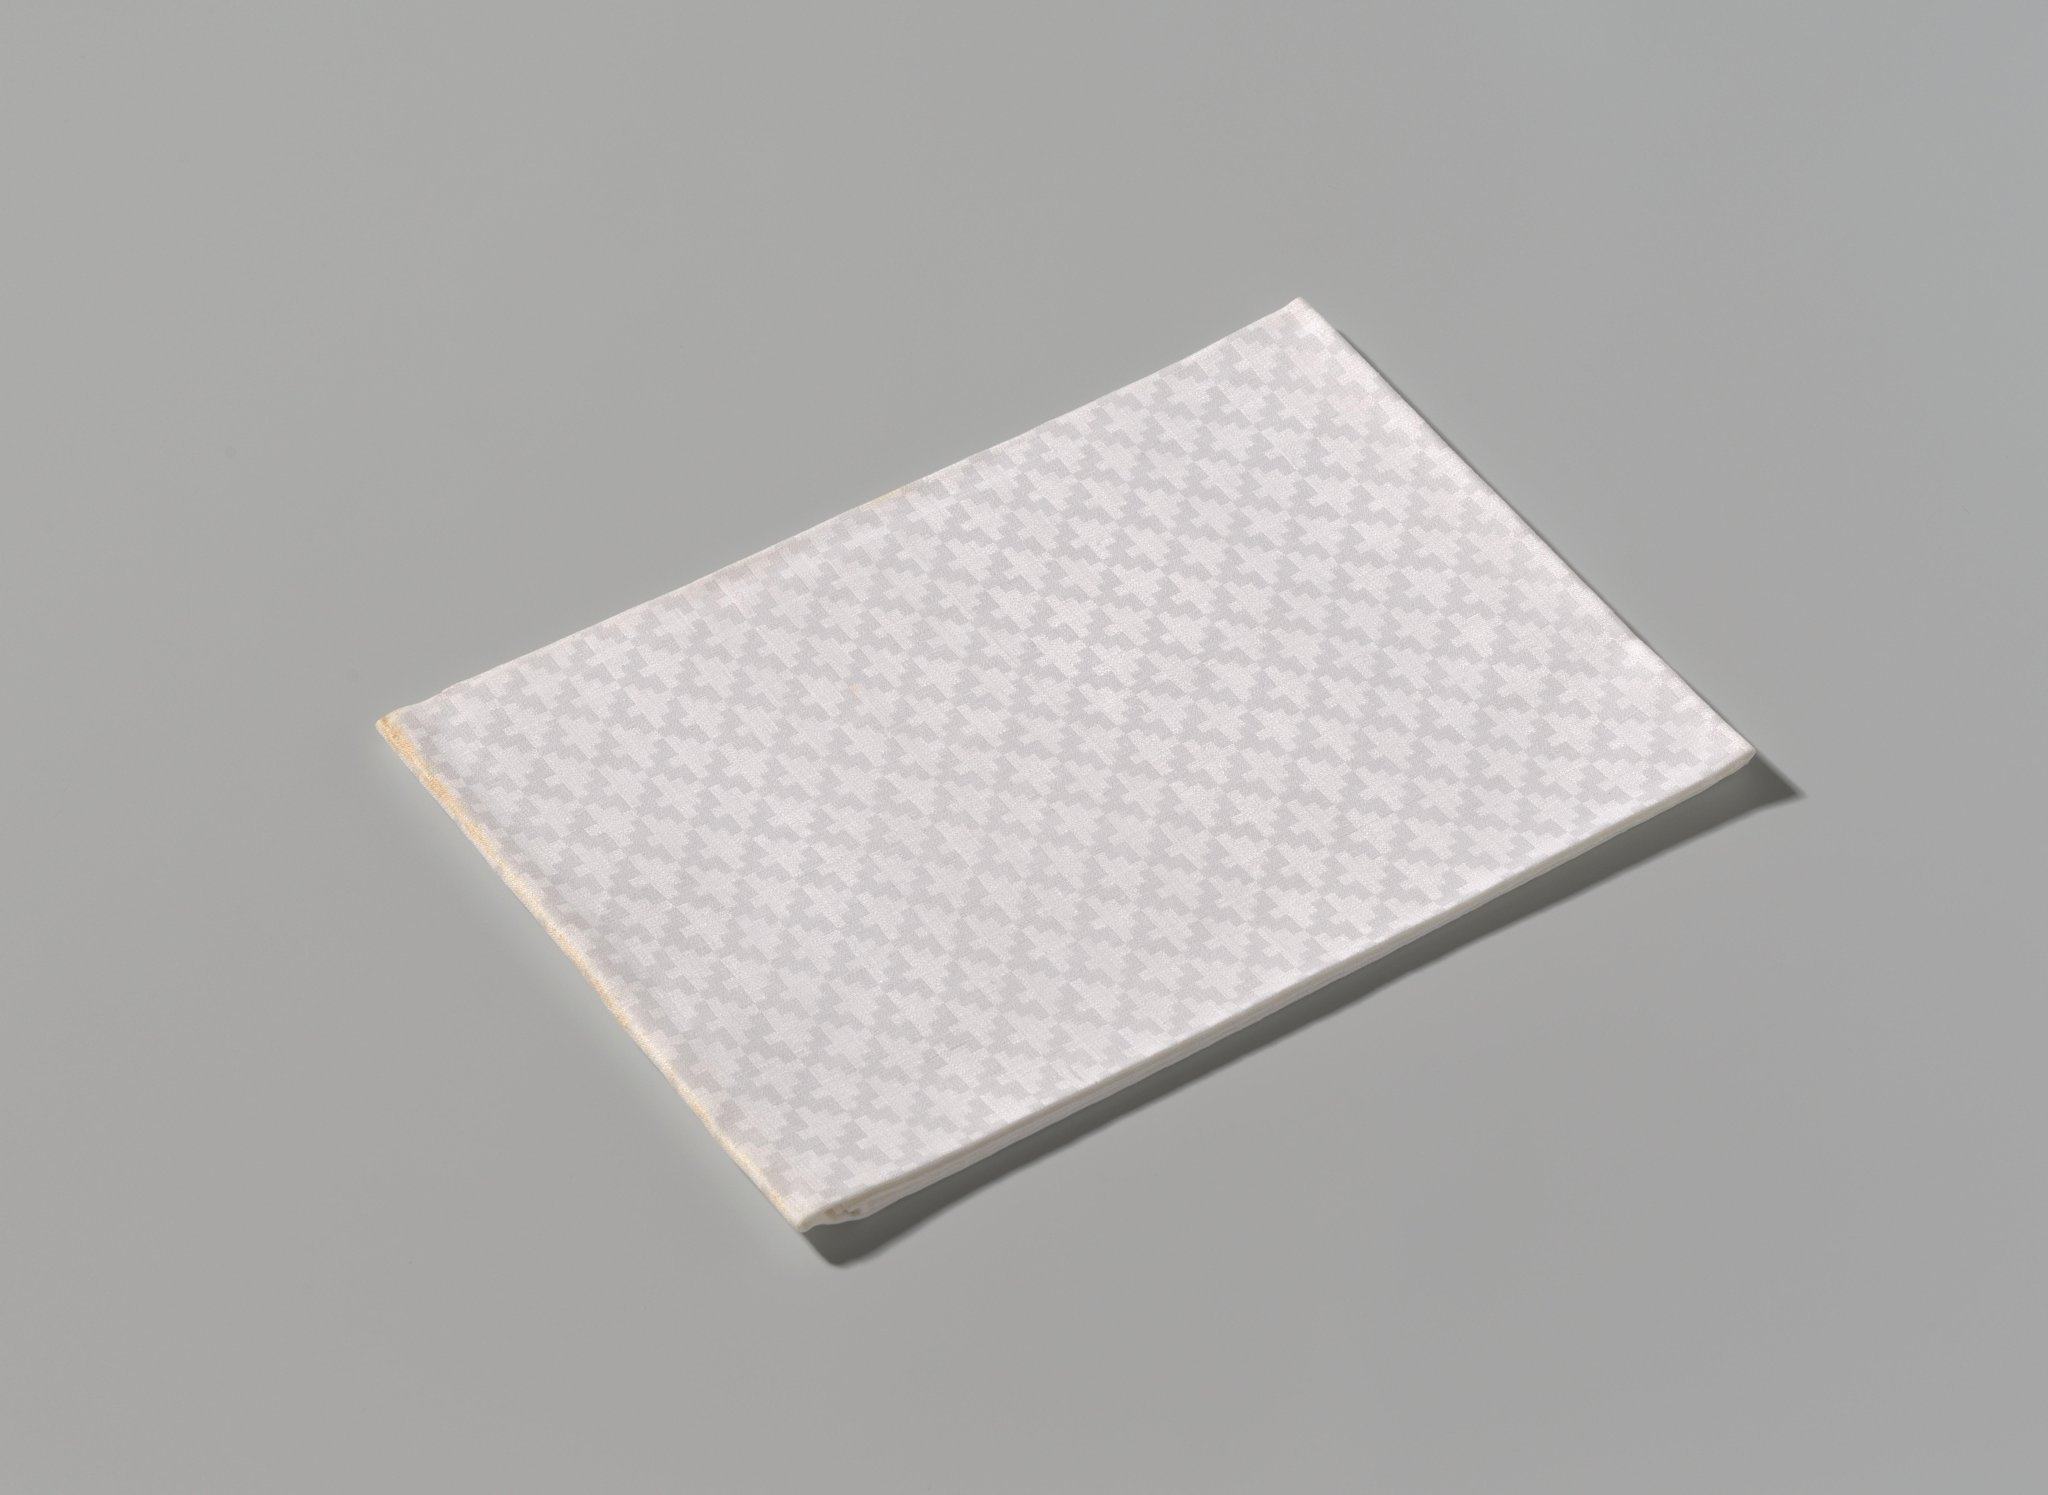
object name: napkin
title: Servet van pellendamast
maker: Anonymous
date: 1800-1900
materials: linen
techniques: weave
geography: netherlands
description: Servet van pellendamast met randen rondom. Het patroon heeft driehoeken met geblokte randen op het veld. De randen zijn gestreept.